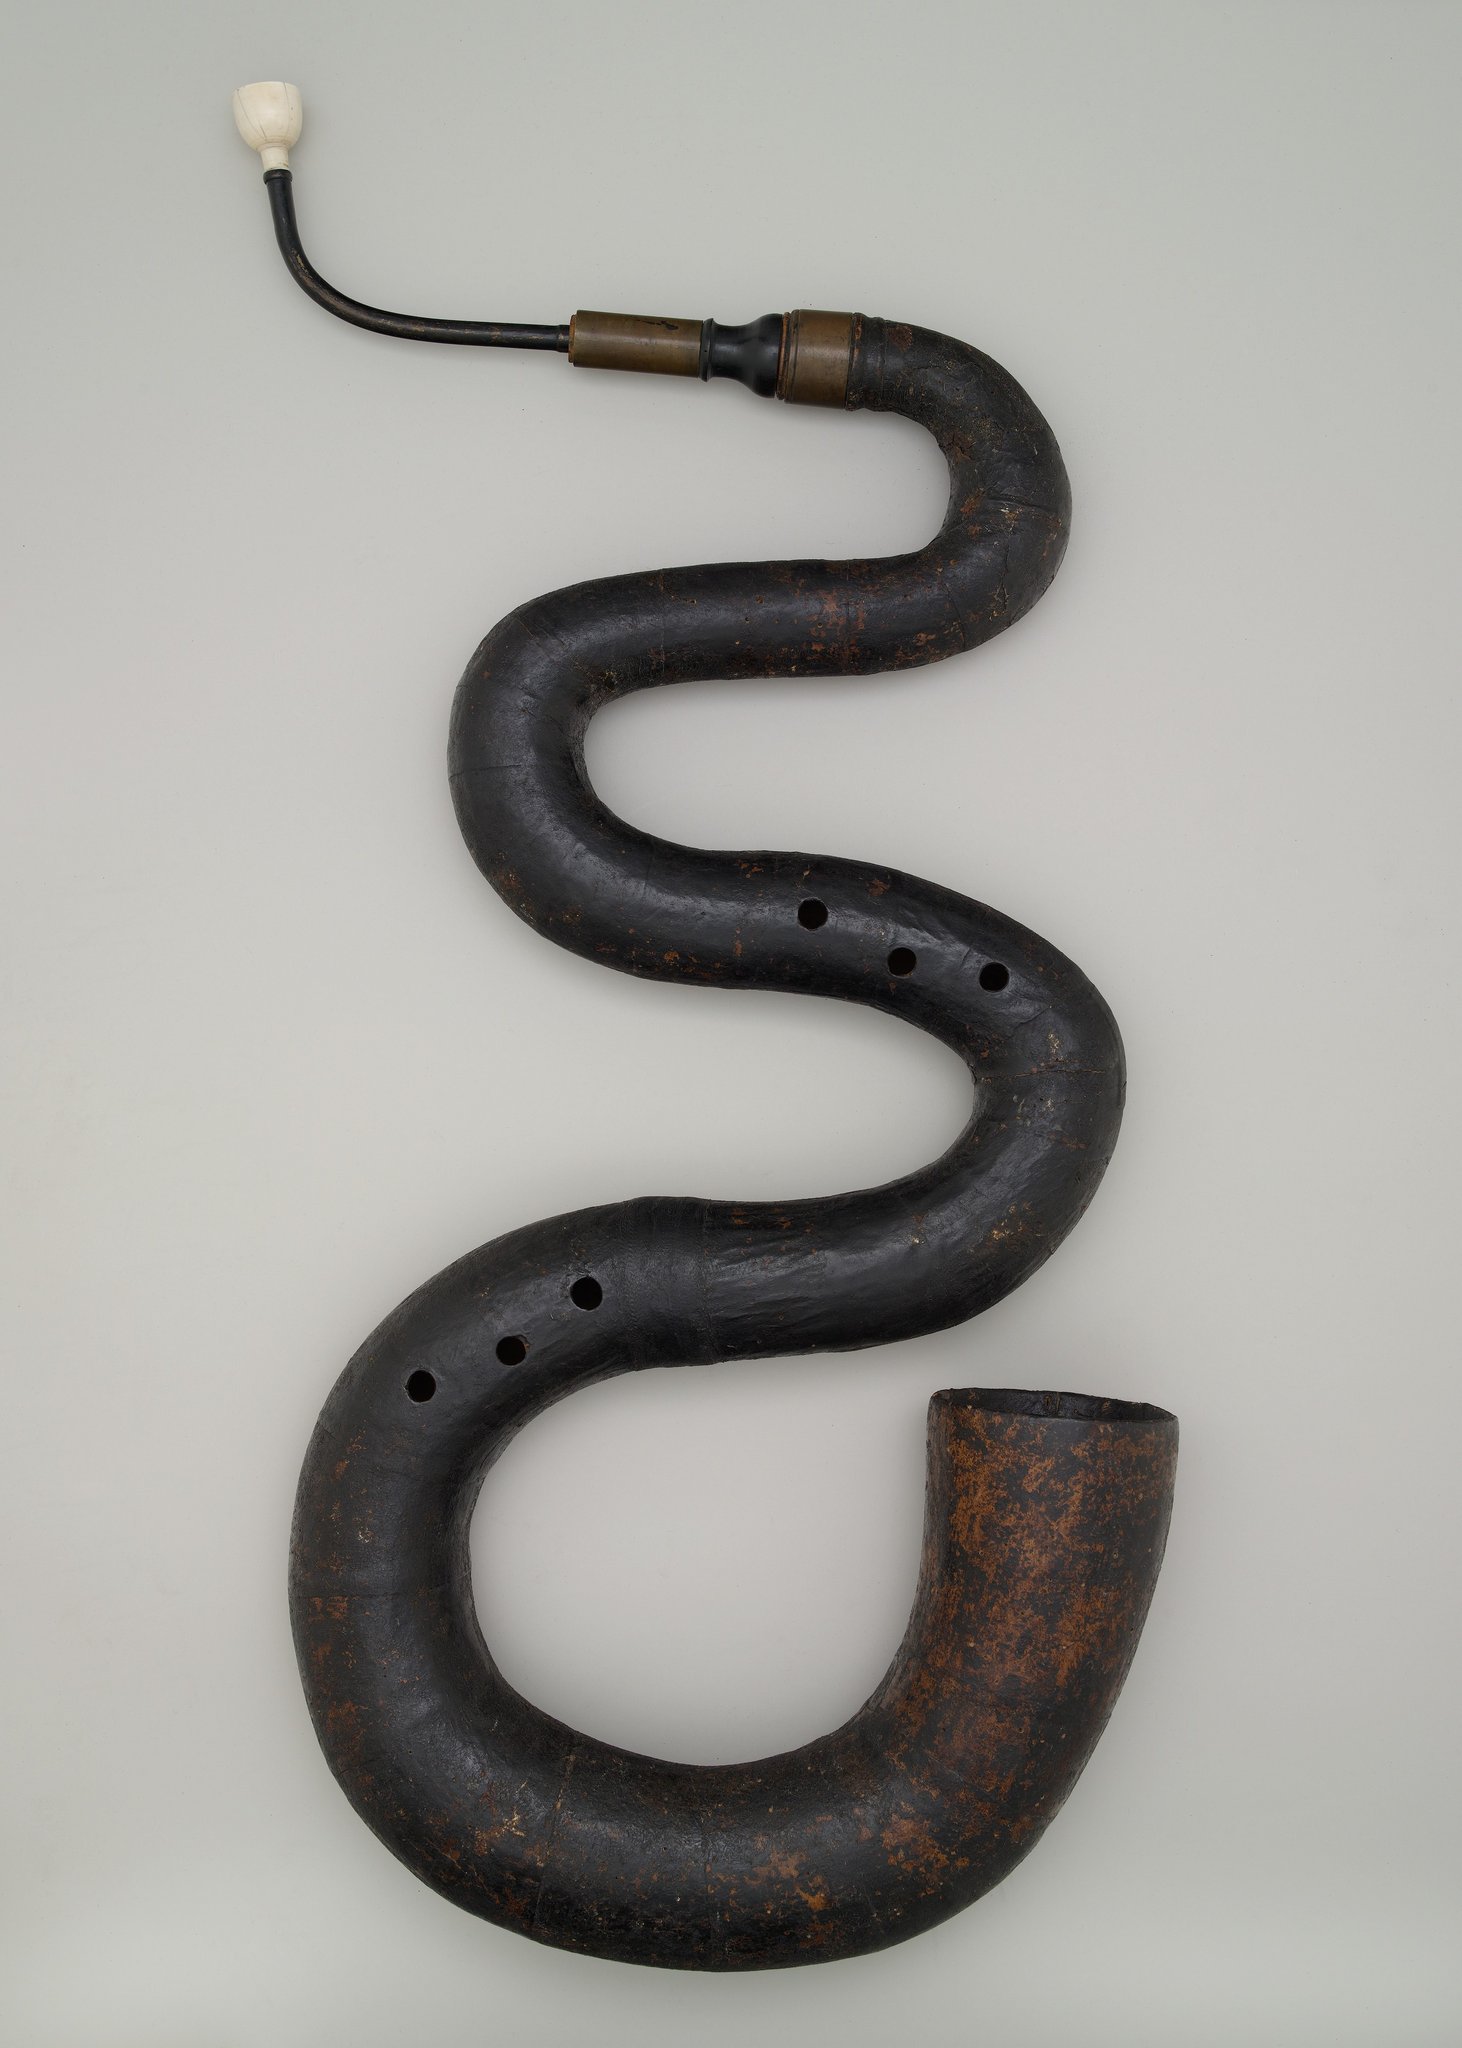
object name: serpent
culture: italian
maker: leopoldo franciolini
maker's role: maker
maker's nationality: italian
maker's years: 1844-1920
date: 1701-1800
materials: brass, ivory, leather, wood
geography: italy